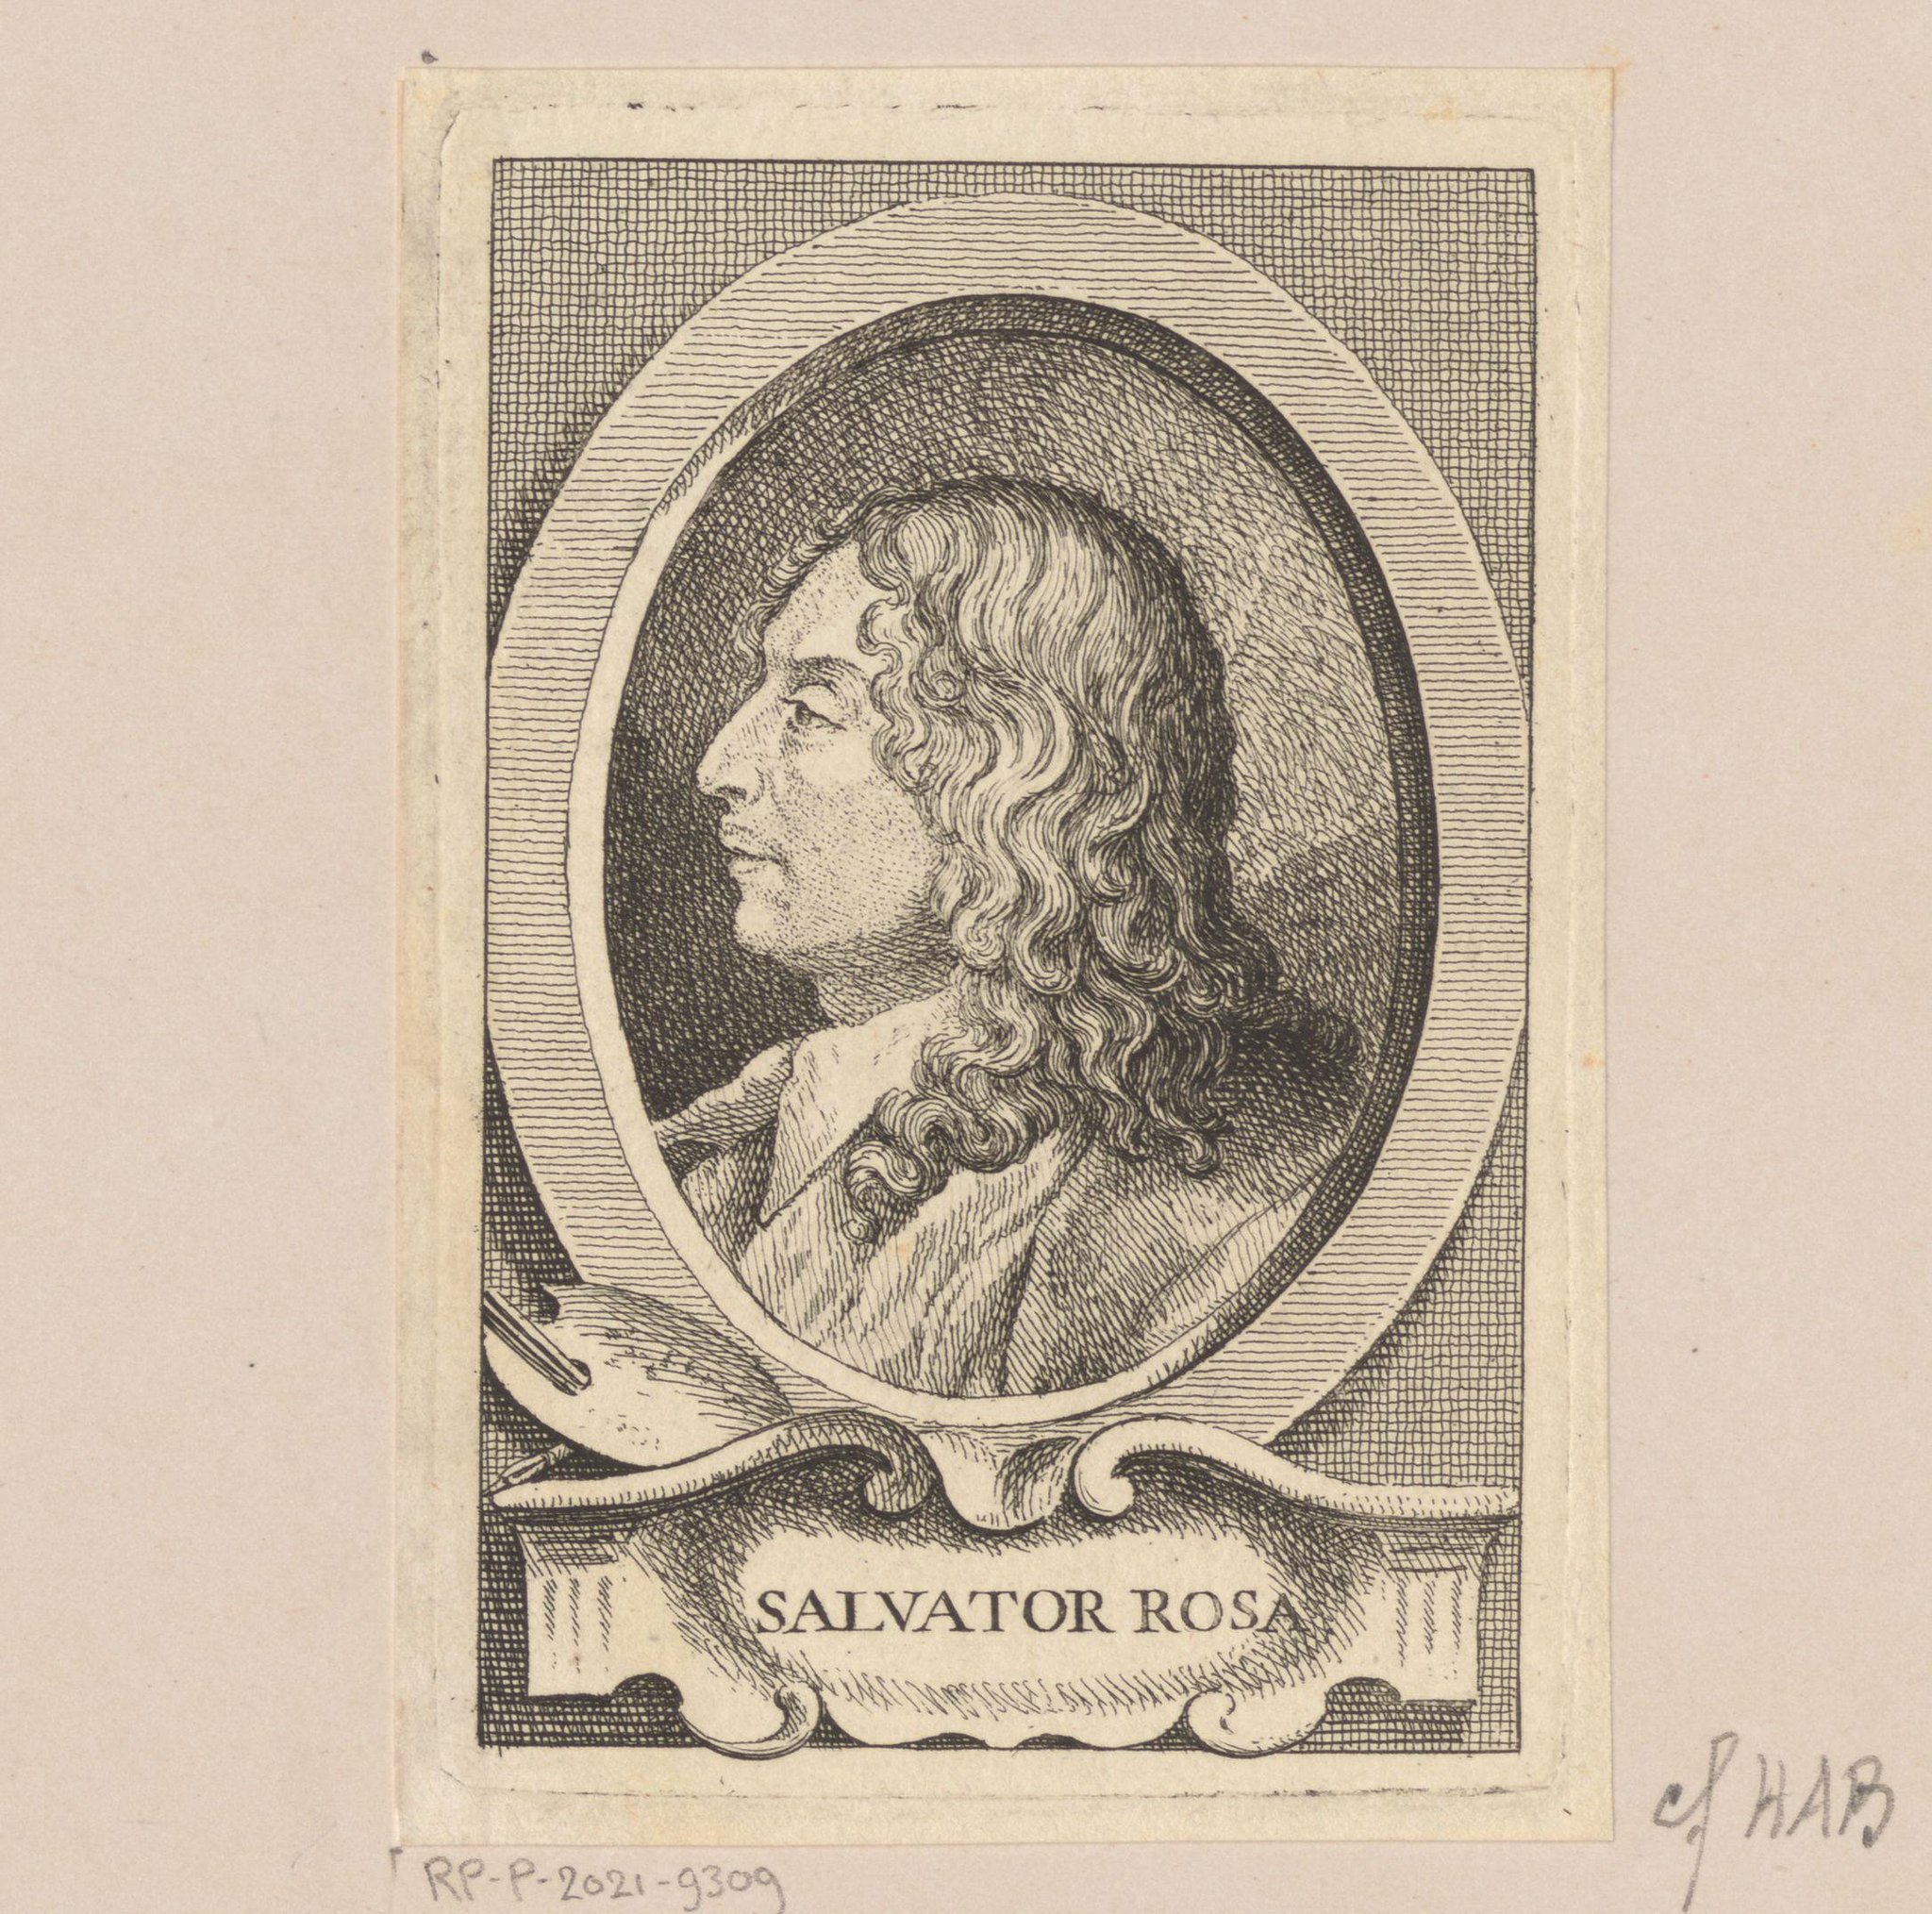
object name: print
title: Portret van Salvator Rosa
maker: Anonymous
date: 1635-1749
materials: paper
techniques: etching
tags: naples, rome, painter, draughtsman, salvator rosa, historical persons, portrait, self-portrait of painter